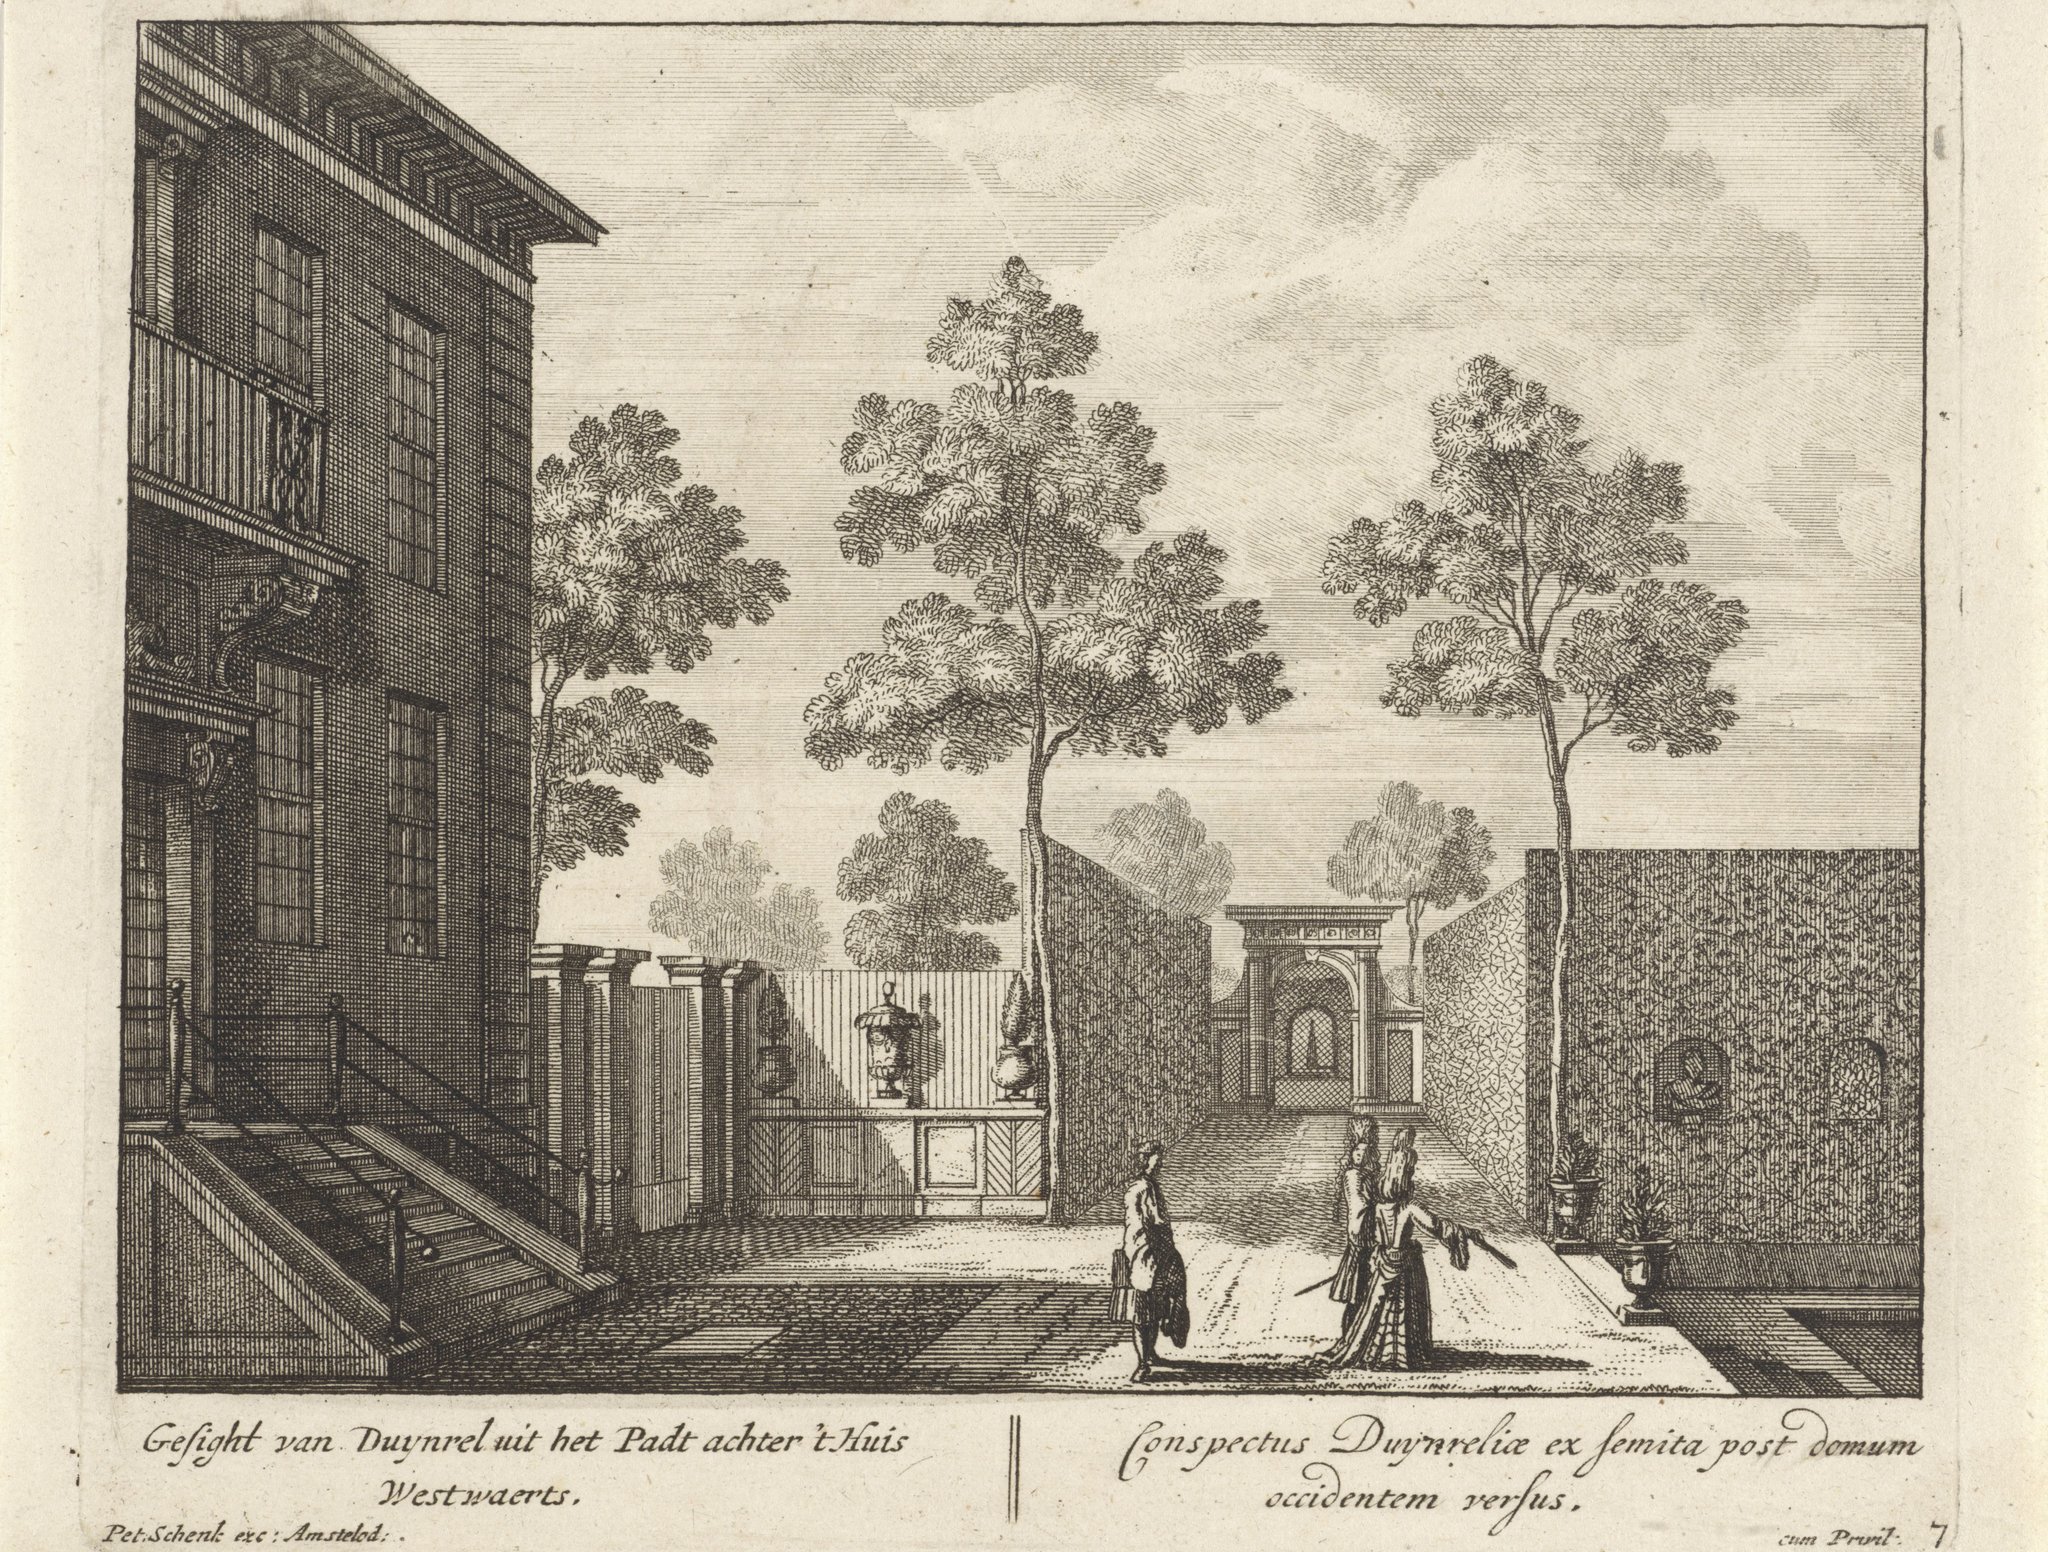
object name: print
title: Gezichten op de buitenplaats Duinrell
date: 1675-1711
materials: paper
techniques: etching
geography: amsterdam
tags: french or architectonic garden; formal garden, country-house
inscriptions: collector's mark: Lugt 2228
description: Pad met drie figuren in de tuin aan de achterzijde van het huis van buitenplaats Duinrell. Het pad loopt richting het westen. Rechtsonder genummerd: 7. Prent uit een serie van zestien prenten van Duinrell.